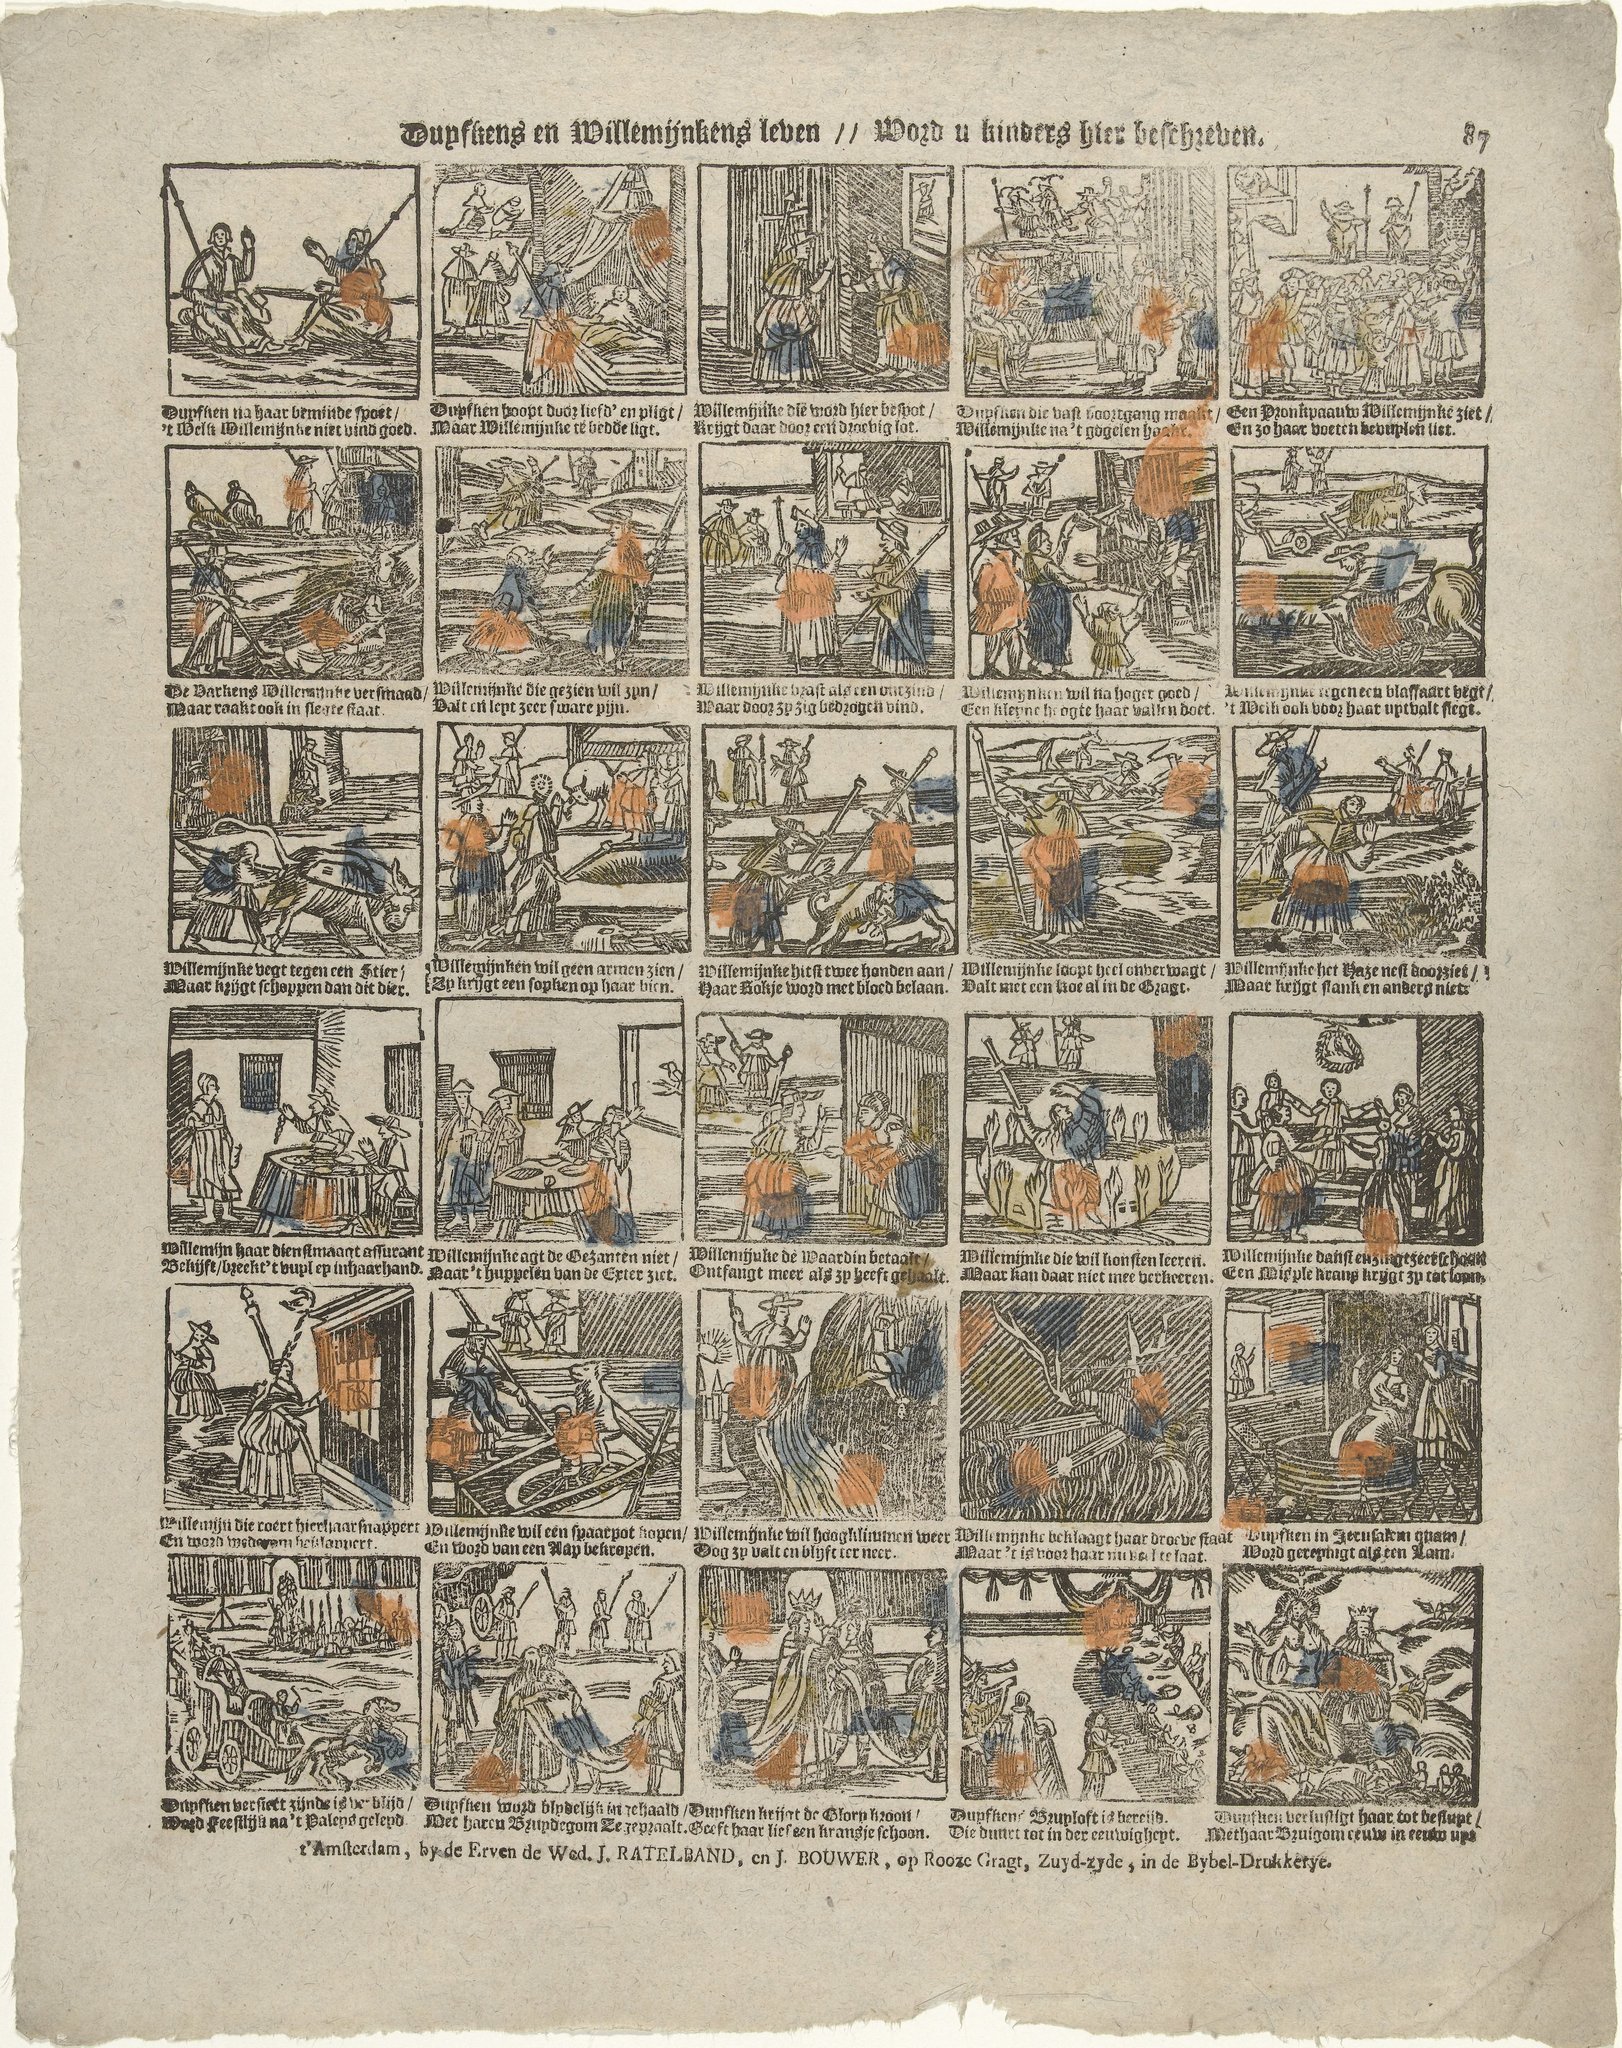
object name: popular print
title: Duyfkens en Willemijnkens leven // Word u kinders hier beschreven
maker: Anonymous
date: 1782-1793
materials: paper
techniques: colour, letterpress printing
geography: netherlands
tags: pilgrimage, pilgrim(s) under way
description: Blad met 30 voorstellingen uit de bedevaart van Duyfken en Willemijn. Onder elke afbeelding een tweeregelig vers. Genummerd rechtsboven: 87.